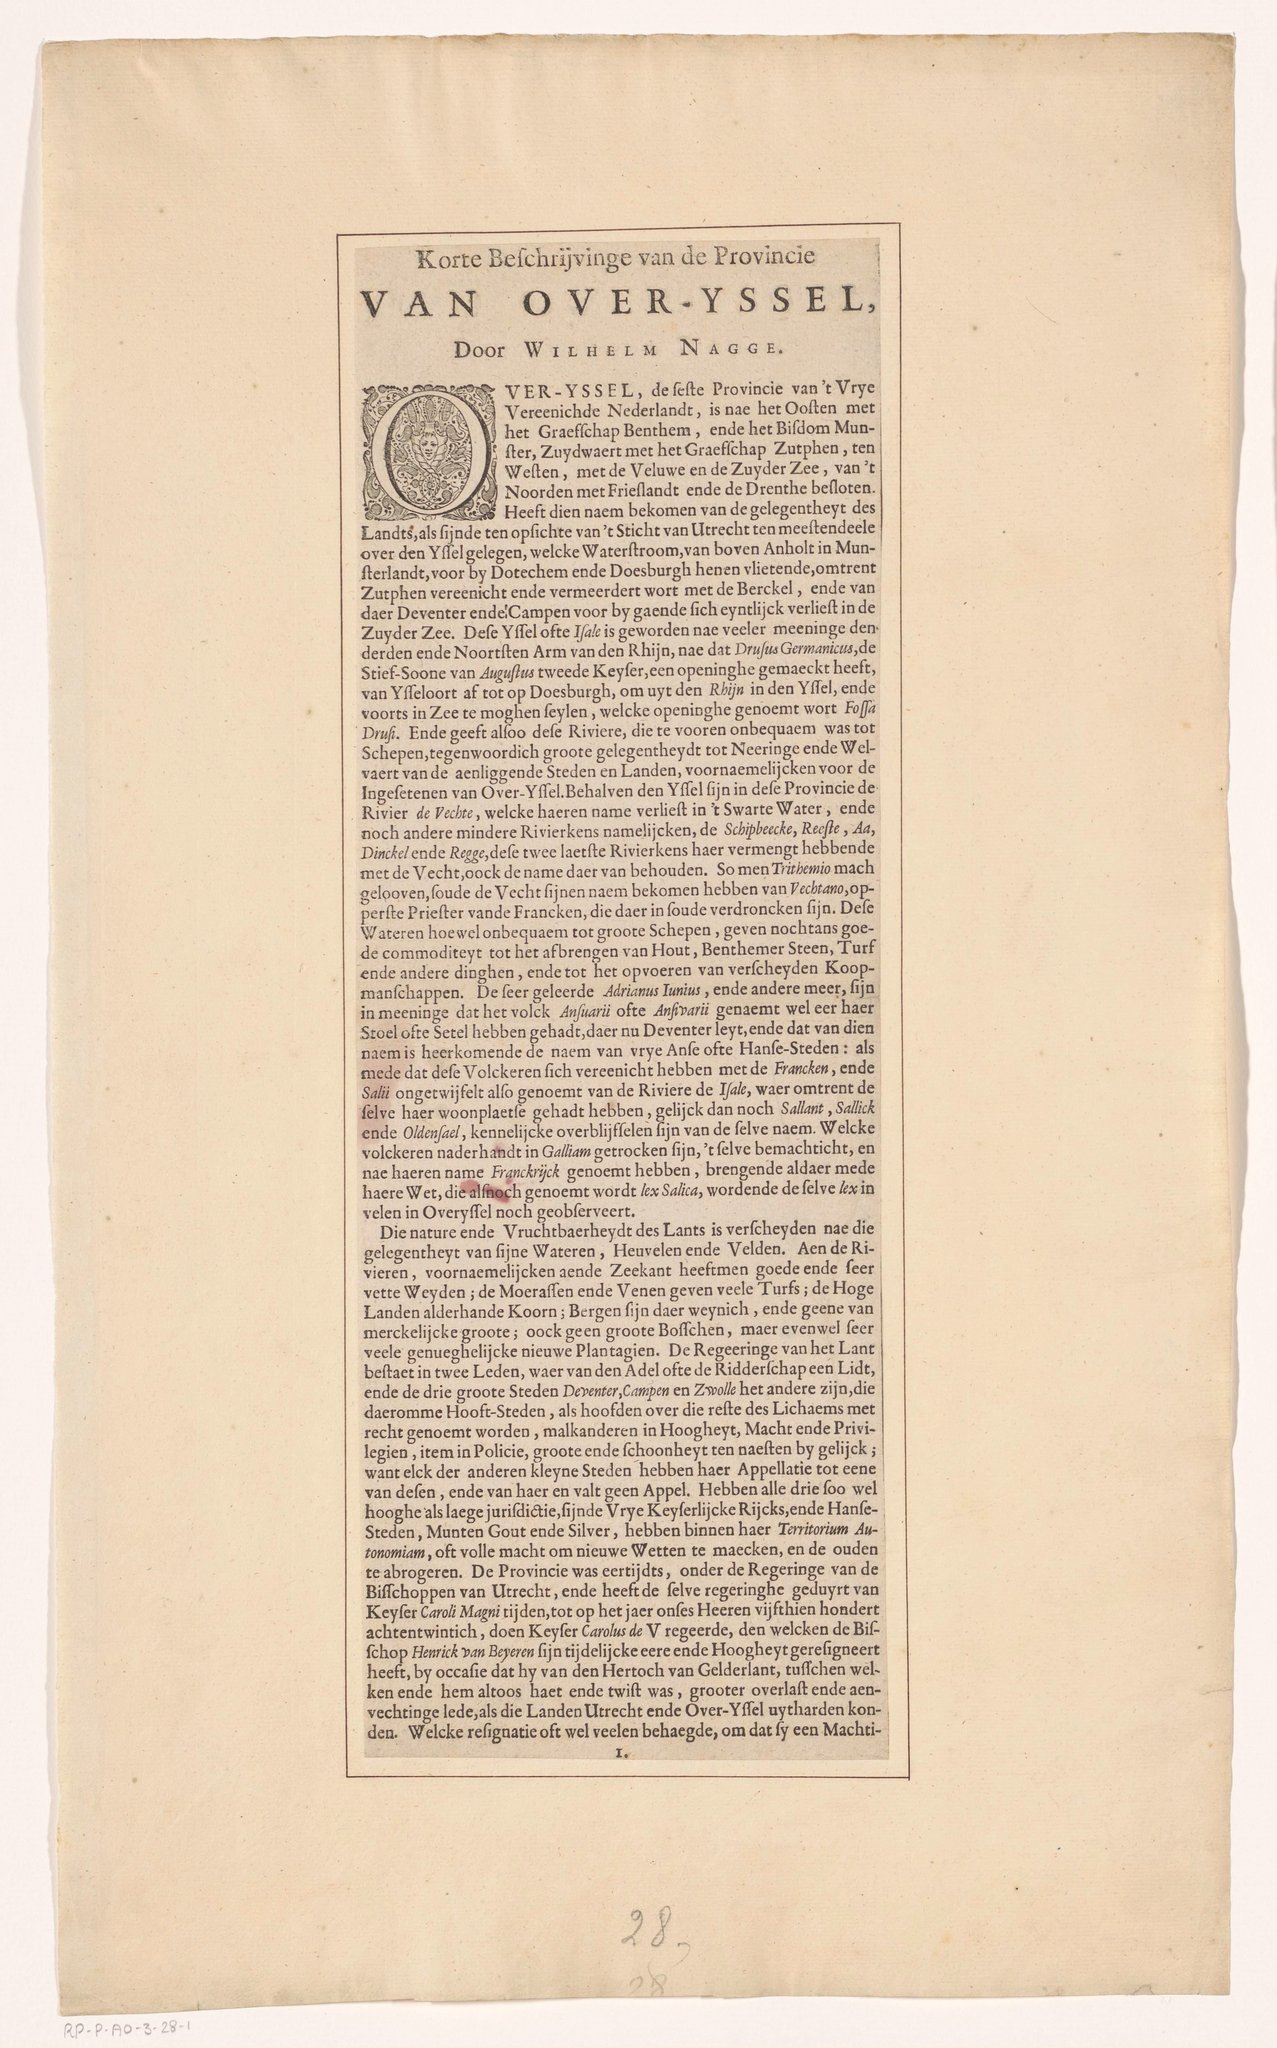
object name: text sheet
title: Korte beschrijvinge van de provincie van Over-yssel, door Wilhelm Nagge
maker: wilhelm nagge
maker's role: geschiedschrijver, predikant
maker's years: 1610-1690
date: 1647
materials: paper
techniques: letterpress printing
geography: twello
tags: drenthe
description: Het is niet duidelijk uit welke publicatie deze tekst komt. Wel is bekend dat deze tekst (of delen ervan) vanaf 1647 geregeld gebruikt is in publicaties en op kaarten.